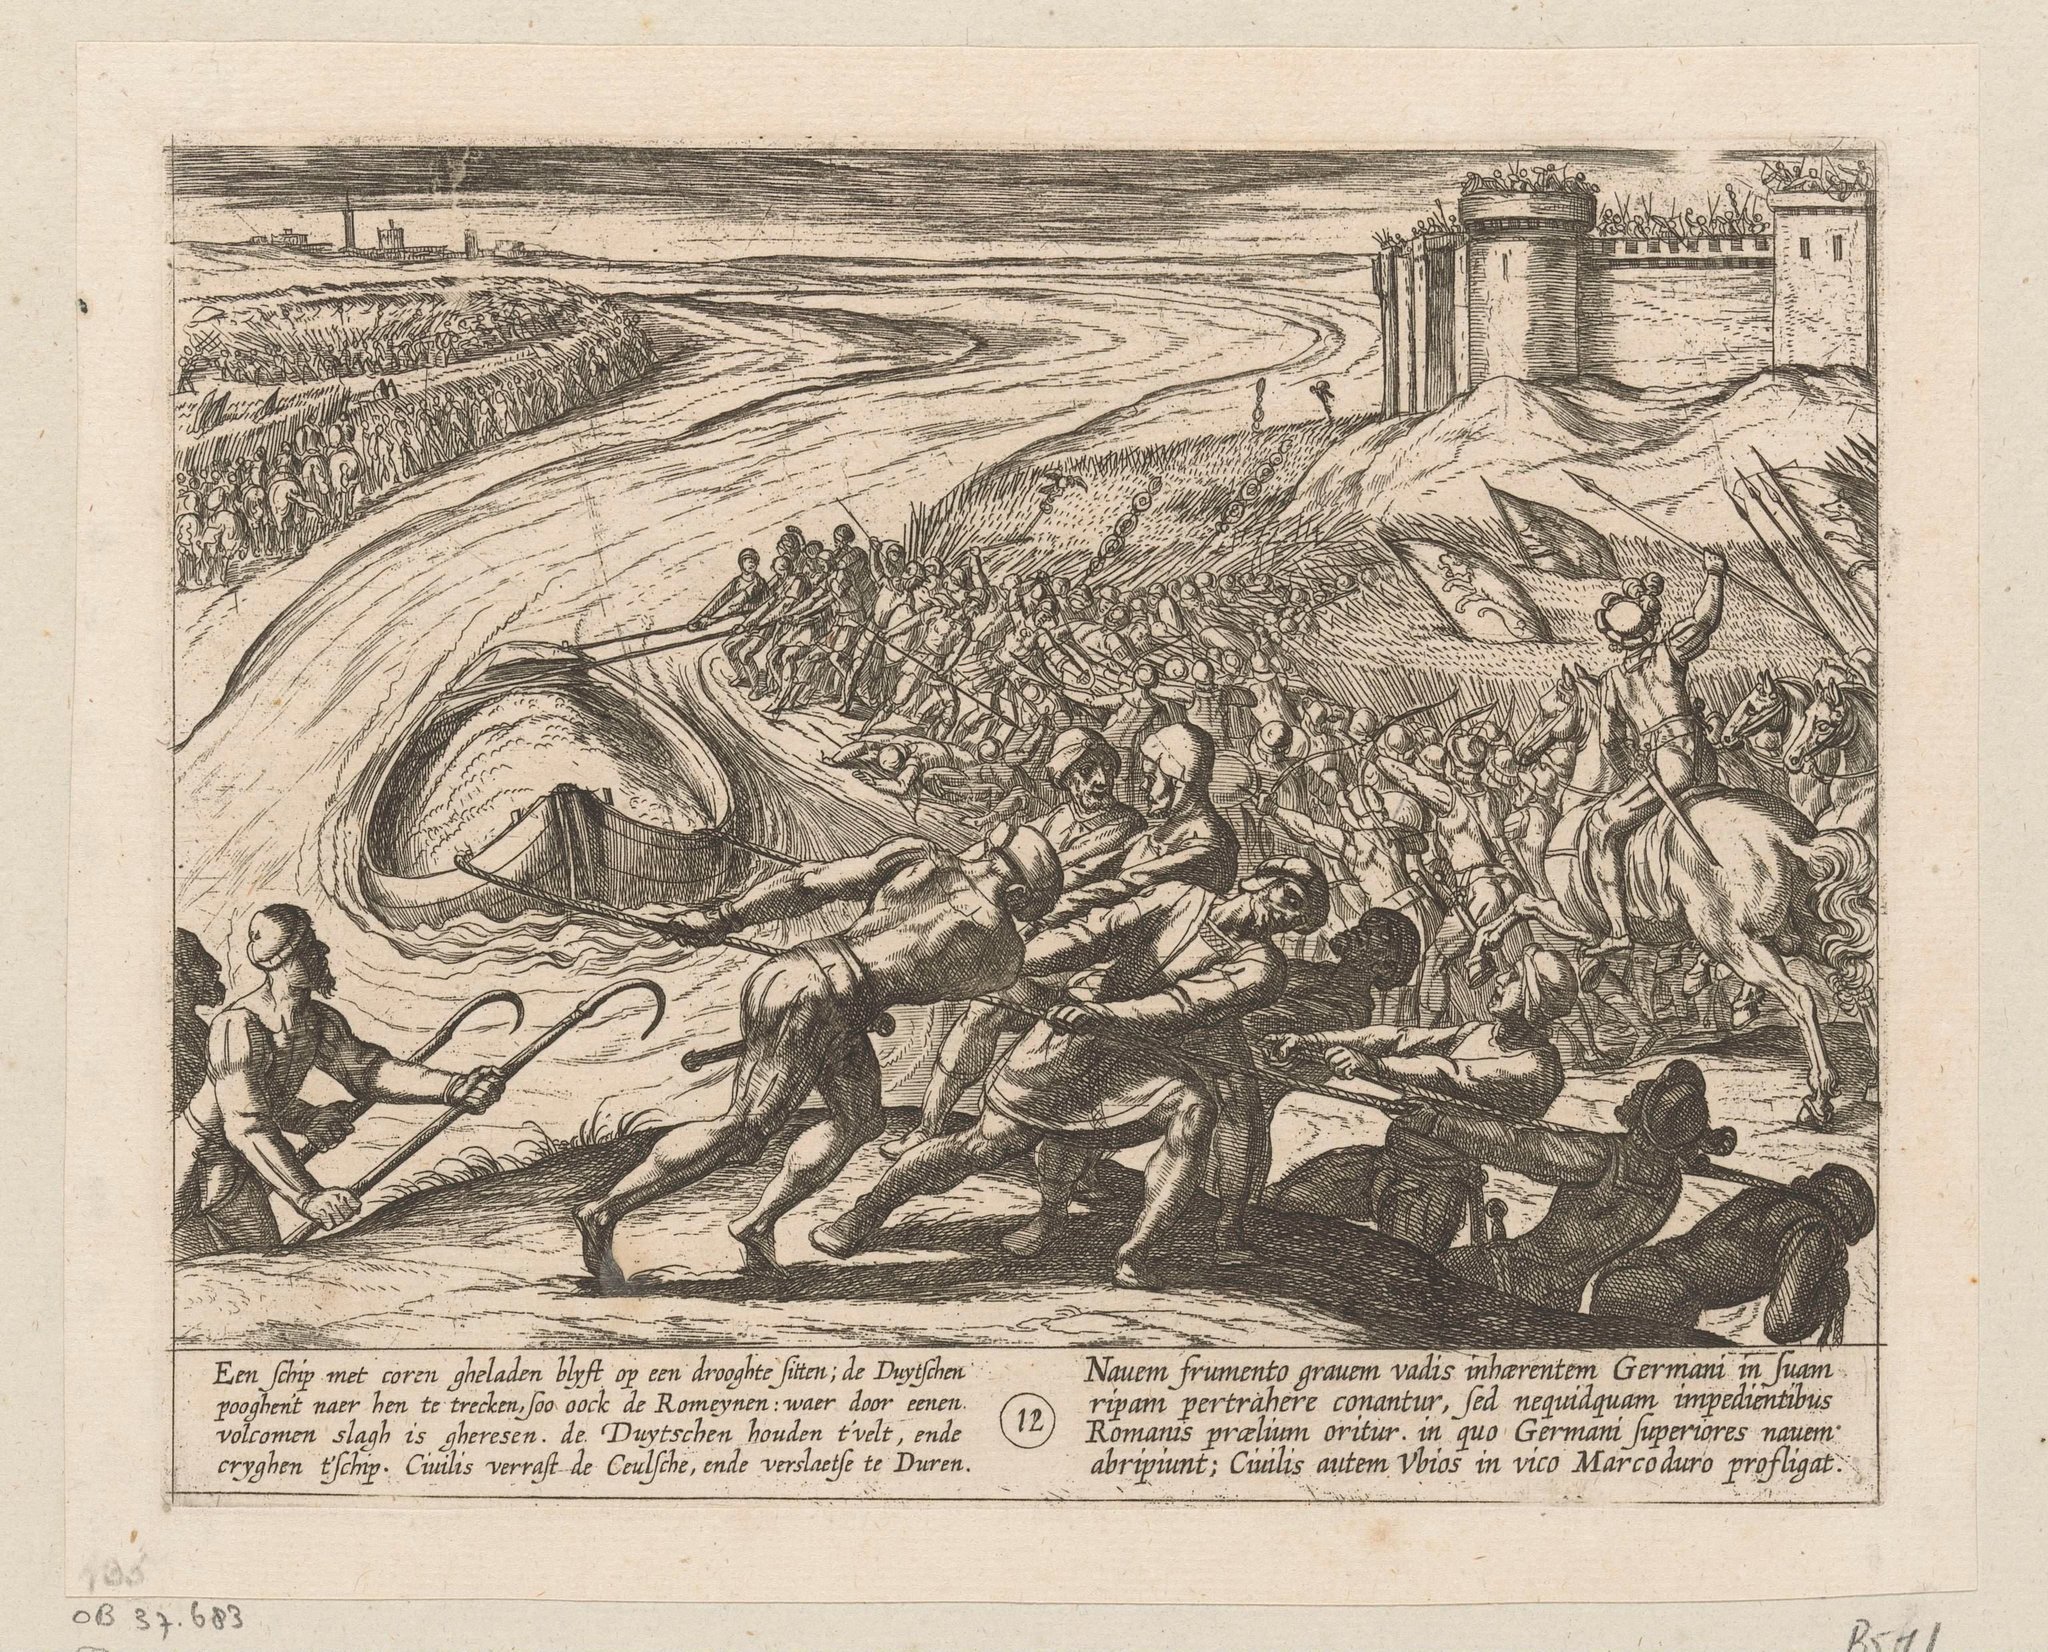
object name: print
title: Batavorum cum Romanis Bellum, à Corn. Tacito / De Batavische Oft Oude Hollandtsche Oorloghe teghen de Romeynen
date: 1612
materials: paper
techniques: etching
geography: italy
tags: battle, fighting in general, extinct, 'historical' peoples (with name), netherlands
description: Het lukt de Bataven om een vastgelopen schuit geladen met koren naar de oever te slepen. Prent nummer 12 in de serie prenten over de Bataafse Opstand: Batavorum cum Romanis bellum / à Corn. Tacito lib. IV & V. : Hist. olim descriptum, figuris nunc aeneis expressum, auctore Othone Vaenio Lugdunobatava = De Batavische oft oude Hollandtsche oorloghe teghen de Romeynen. Otto Vaenius, Antwerpen 1612. Onderaan twee verzen van vier regels in het Nederlands en in het Latijn. Zonder tekst op achterzijde.